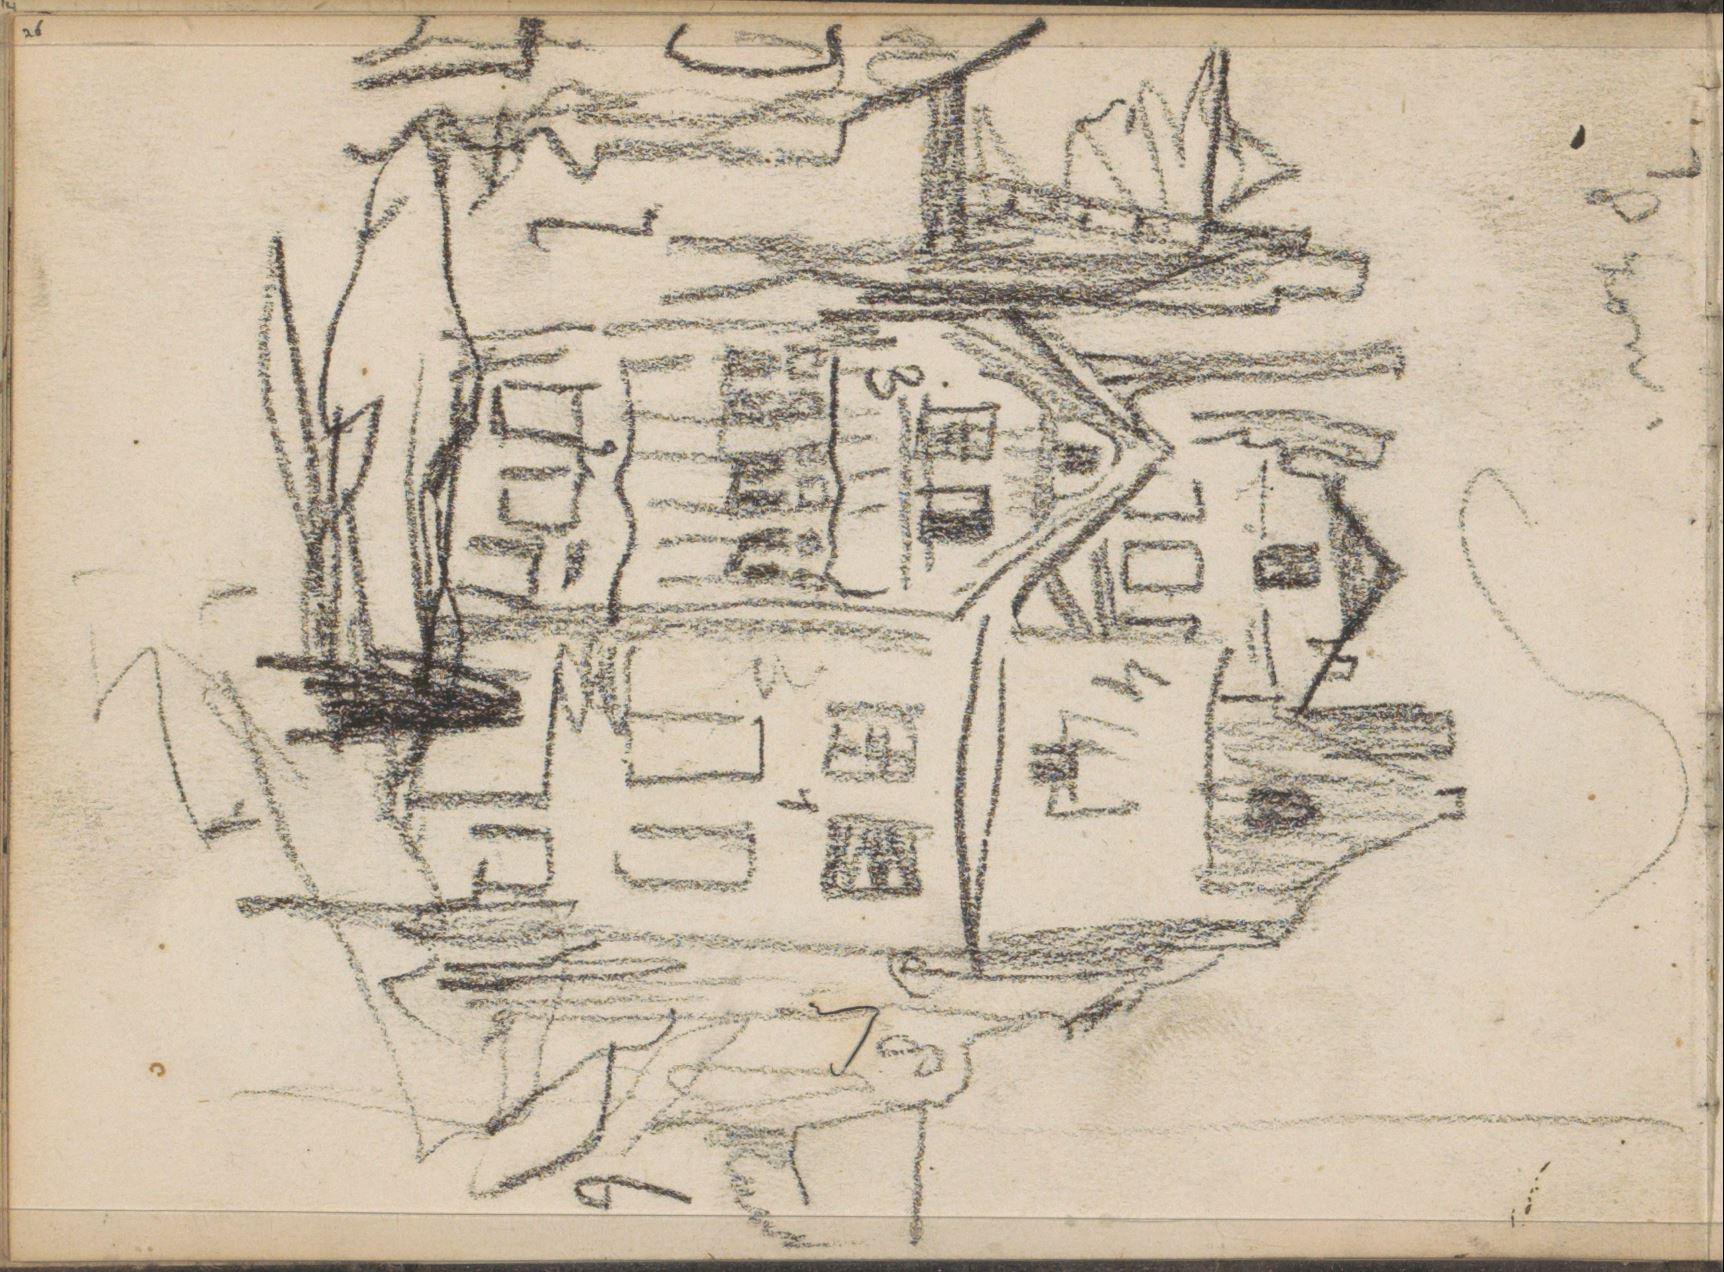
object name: sketchbook leaf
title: Straatgezicht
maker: marius bauer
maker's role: draughtsman, print maker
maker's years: 1867-1932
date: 1877-1932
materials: chalk, paper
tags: street (+ city(-scape) with figures, staffage)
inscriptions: kleurnotitie, handgeschreven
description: Pagina 26 uit een schetsboek met 32 bladen.